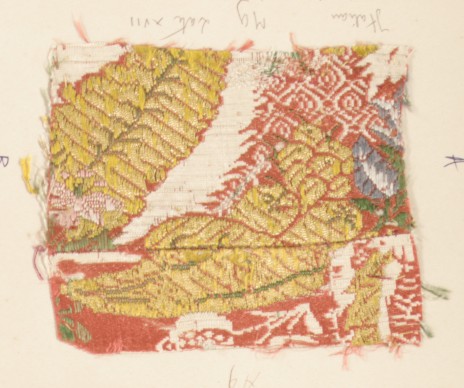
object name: fragment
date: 1667-1800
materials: metal thread, silk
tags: flowers